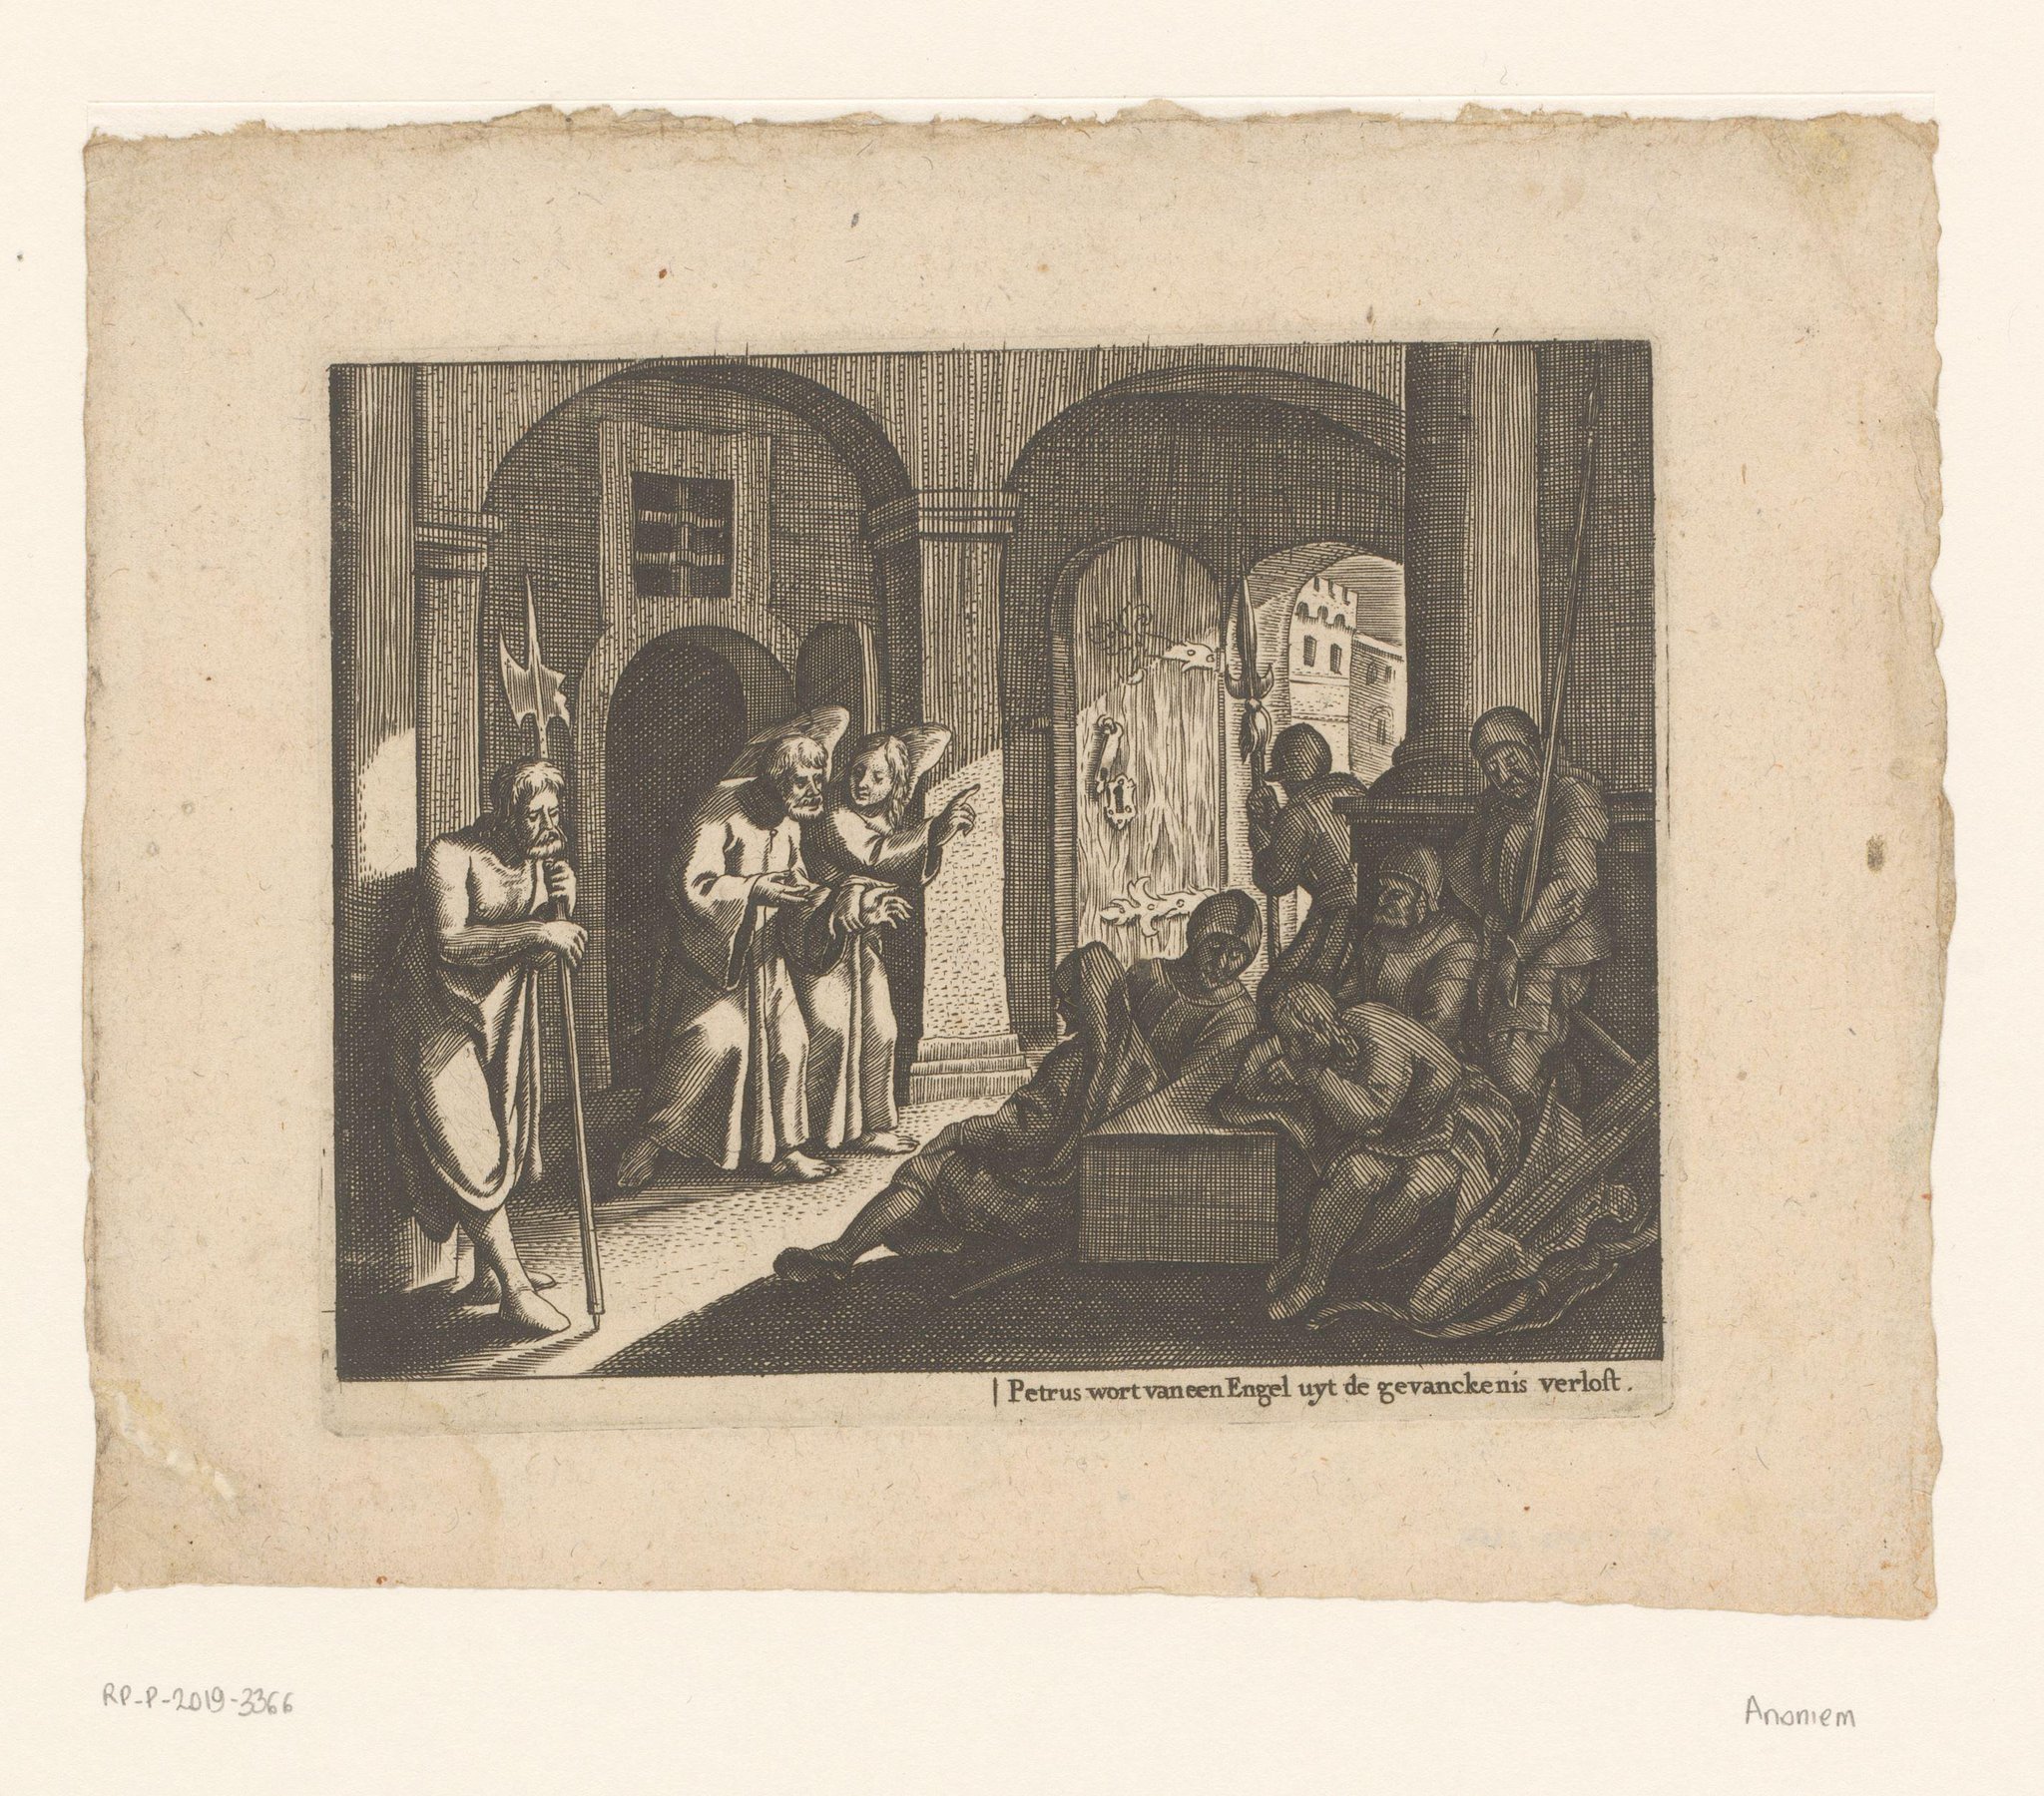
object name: print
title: Petrus wordt door een engel uit de gevangenis bevrijd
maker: Anonymous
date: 1600-1699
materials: paper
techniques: engraving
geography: netherlands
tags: the angel leads peter past the sleeping guards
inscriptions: collector's mark: Lugt 2228